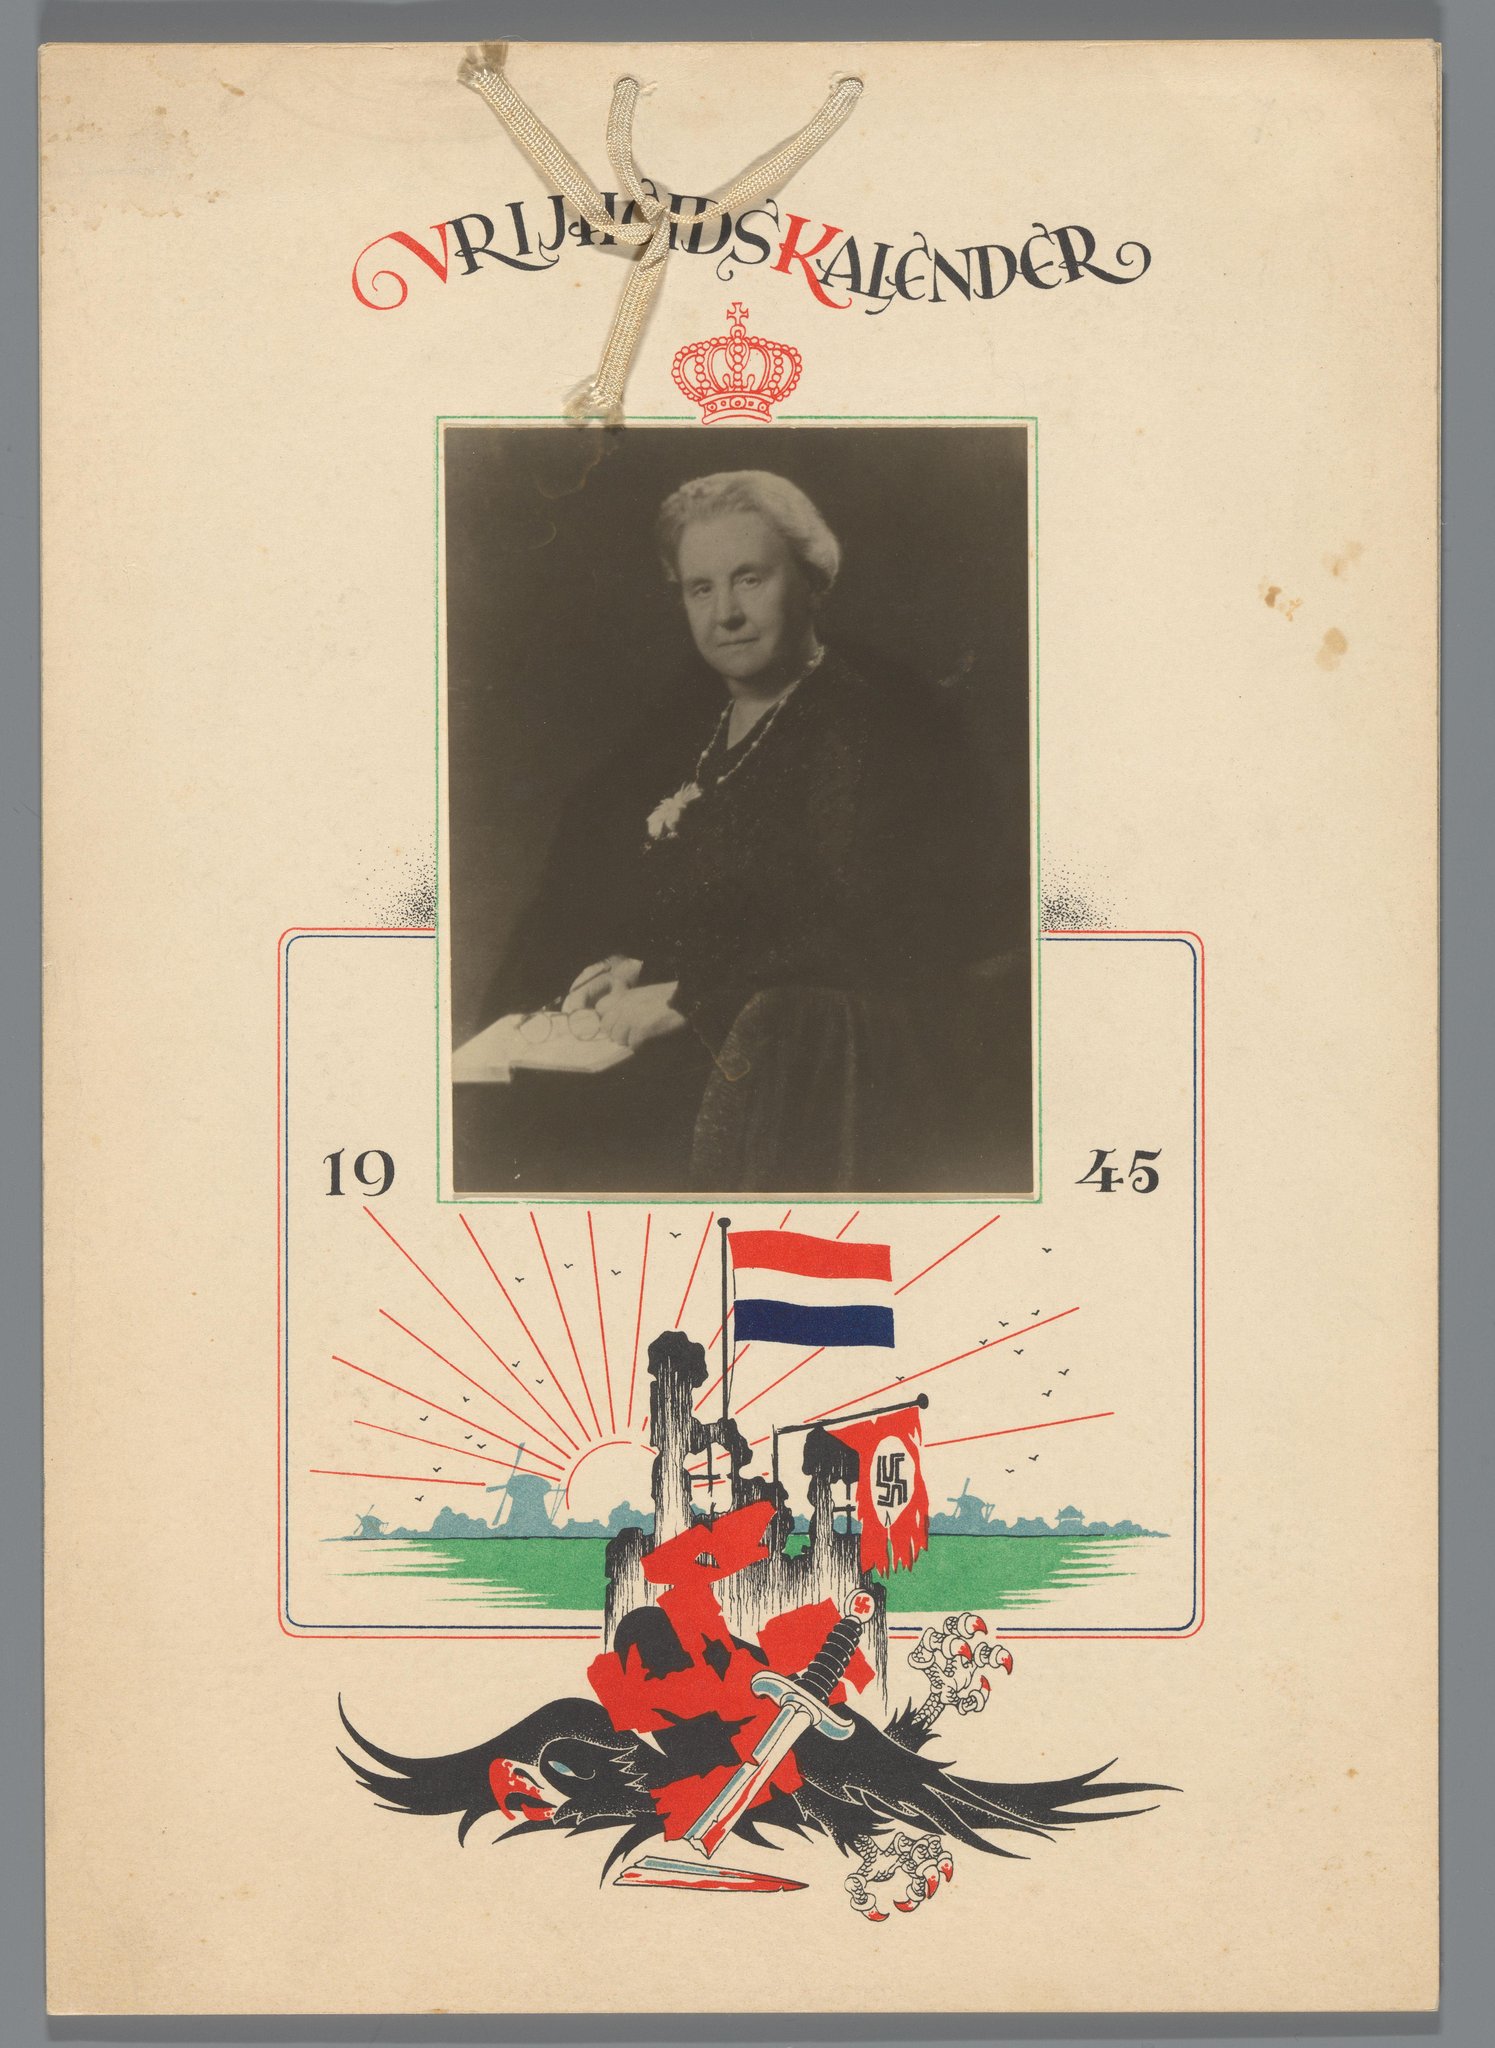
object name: calendar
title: Vrijheidskalender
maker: Anonymous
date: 1945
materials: paper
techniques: lithograph, gelatin silver print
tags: queen, war, netherlands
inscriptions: inscription: ‘COLOPHON/ Deze kalender voor het jaar 1945 werd/ in September 1944 in het verborgene/ gedrukt. Gezien de groote vraag/ naar deze kalender en de/ nog grootere nood, heeft/ ons doen besluiten/ deze tweede druk/ te doen ver-/ schijnen./ Tweede druk/ De opbrengst van deze tweede druk werd eveneens/ bestemd voor slachtoffers van de huidige tyrannie.’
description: Kalender voor het jaar 1945 met portret van koningin Wilhelmina en zeven anti-Nazi karikaturen.